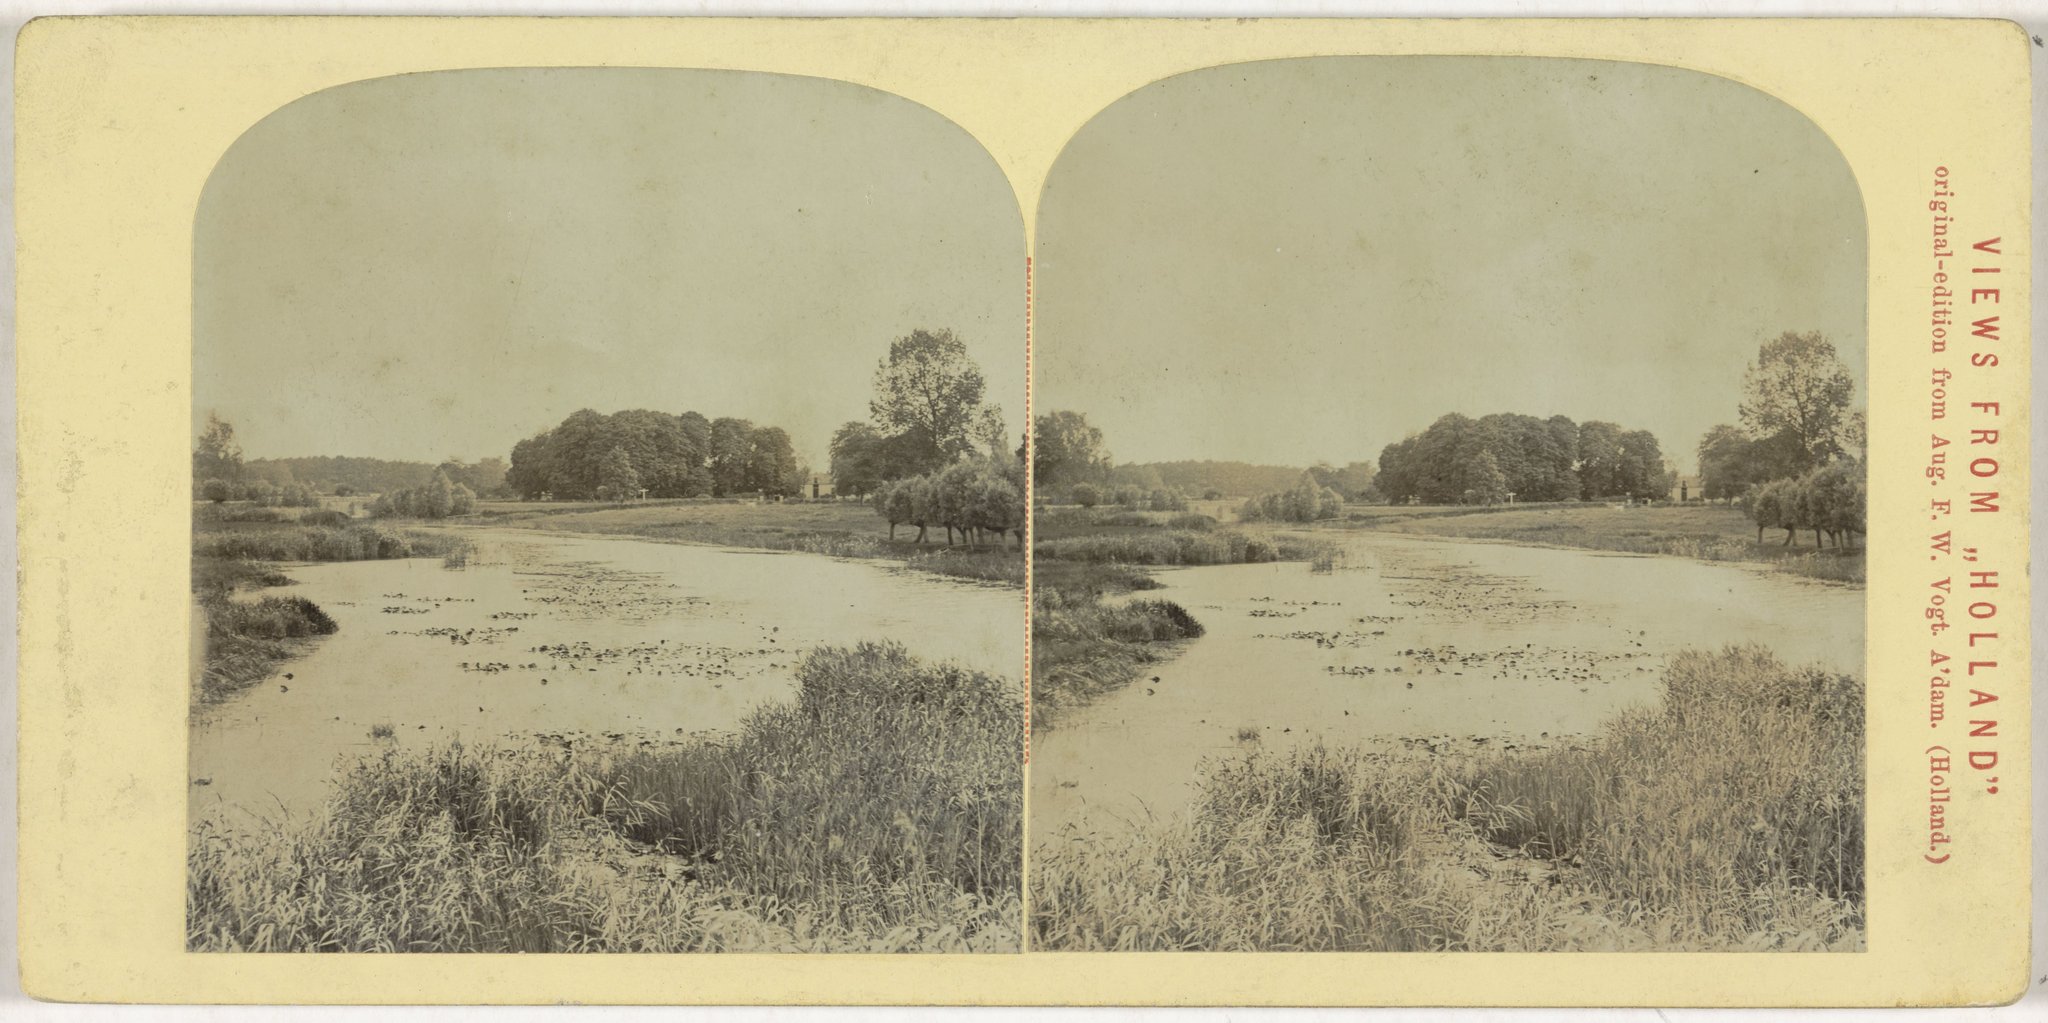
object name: stereograph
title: Oude IJssel bij Voorst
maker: august frederik willem vogt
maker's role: fotograaf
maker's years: 1871-1922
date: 1870-1920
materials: cardboard, paper, photographic support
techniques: gelatin silver print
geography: amsterdam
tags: netherlands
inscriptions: number: ‘25’, annotation: ‘de oude IJsel bij Voorst’, inscription: ‘VIEWS FROM ''HOLLAND''’